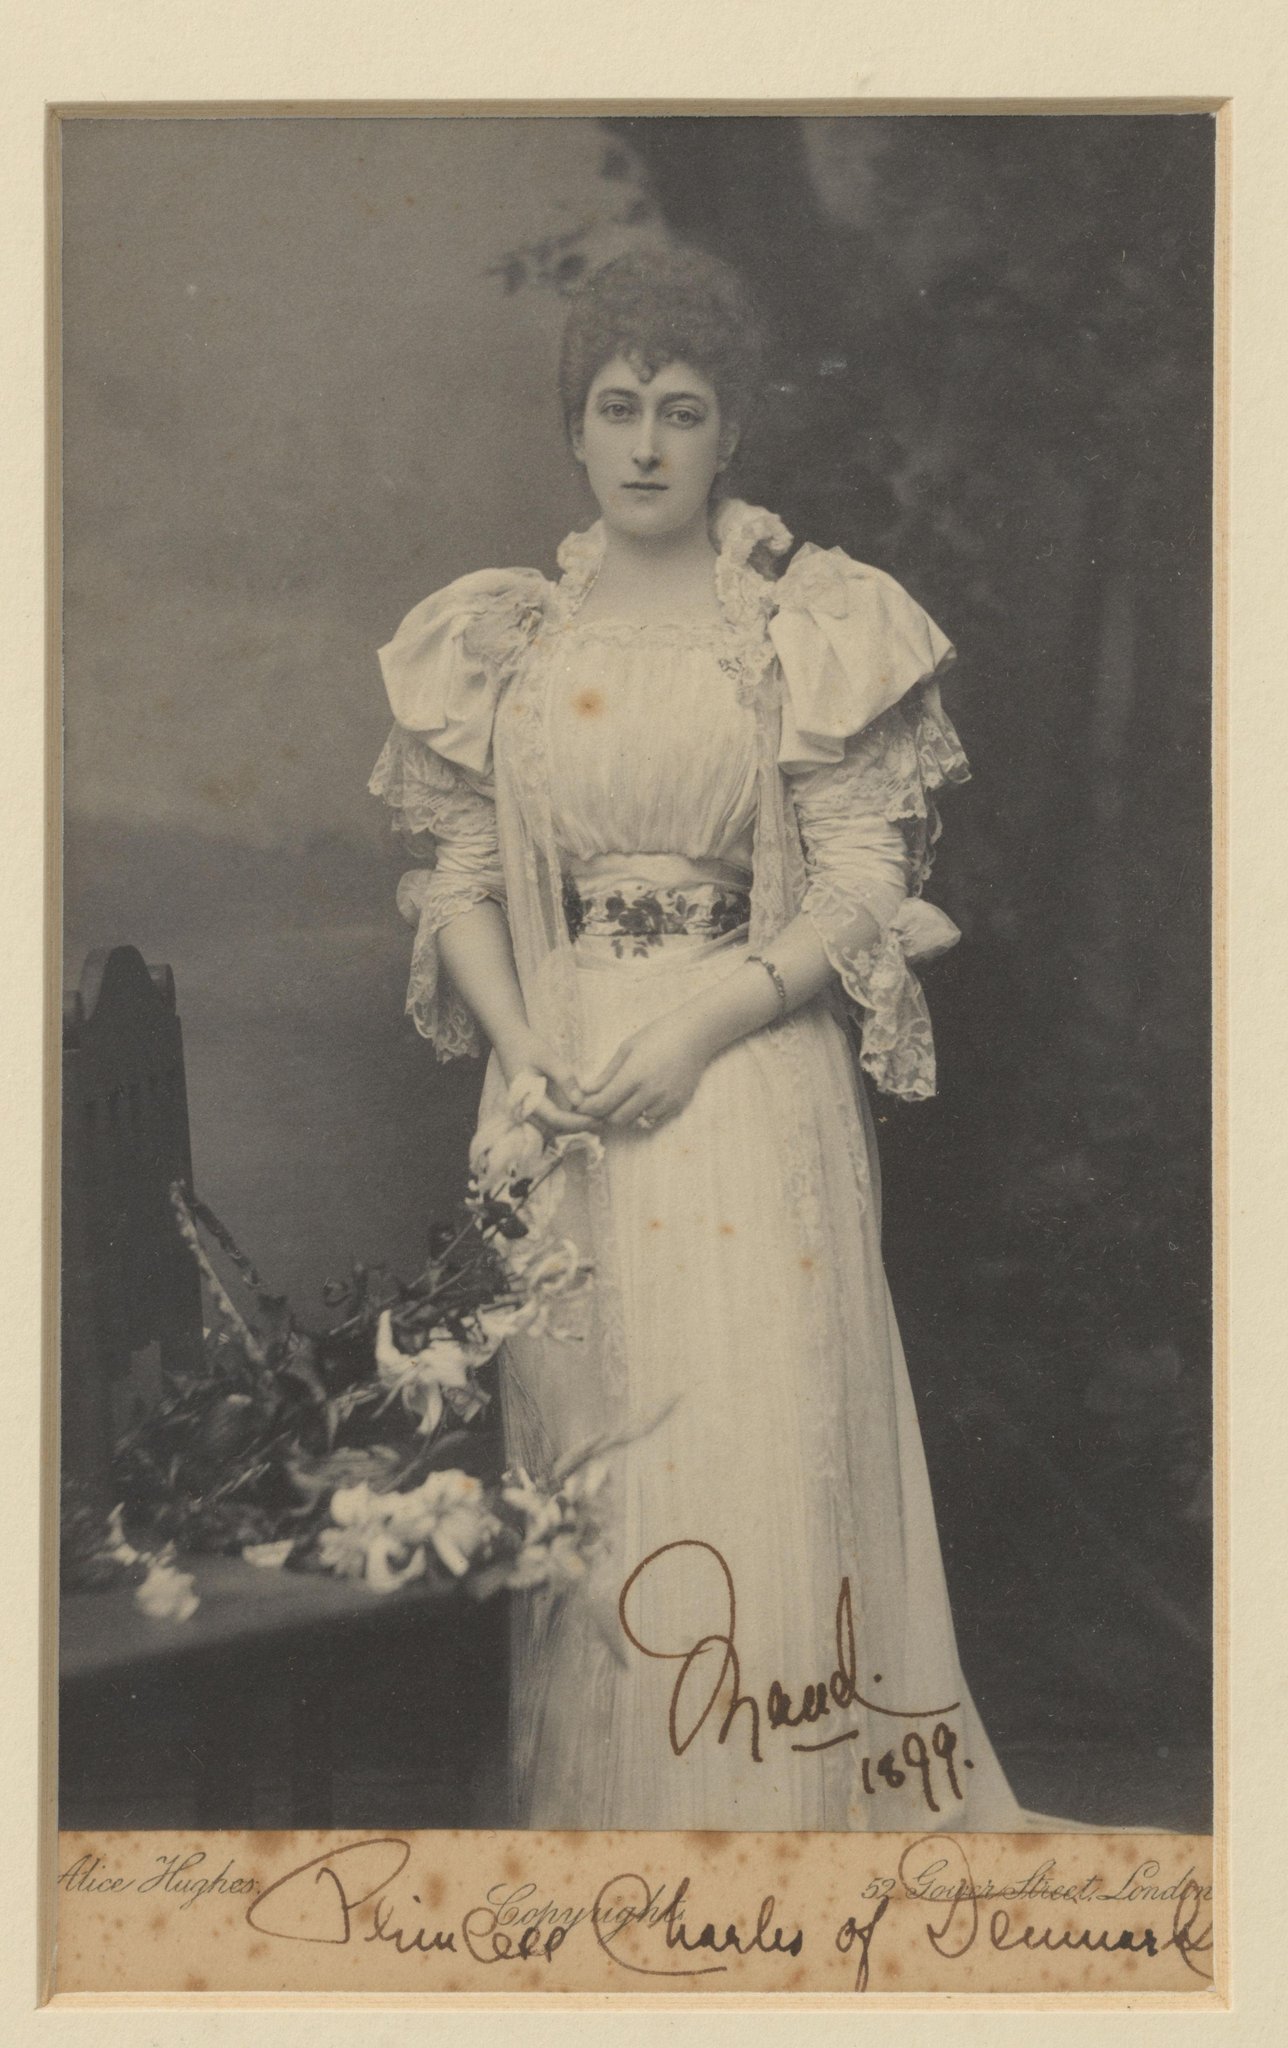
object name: frame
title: Portret van Maud, hertogin van Noorwegen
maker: alice hughes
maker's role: fotograaf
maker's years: 1857-1939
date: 1899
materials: paper, cardboard, glass, metal, pressure sensitive tape, wood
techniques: gelatin silver print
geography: london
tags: historical persons - bb - woman, family of the sovereign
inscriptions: copyright notice: ‘Copyright’, address: ‘52 Gower Street London’, inscription: ‘Maud 1899/ Princess Charles [?] of Denmark’, inscription: ‘Maud, koningin van Noorwegen/ geboren dochter van Edward VII/ van Engeland en Alexandra/ tezamen met zelfde zijn ingelijst [?]/ ingelijst portret van Alexandra/ (foto ALice Hughes) gekocht/ [...] 1981 van partij van Clarke,/ Manchester (vraagprijs van de/ twee foto's, waarvan de foto van/ Alexandra gepubliceerd is in Gurnsheim,/ Hasting, 1e druk, f 375-)’